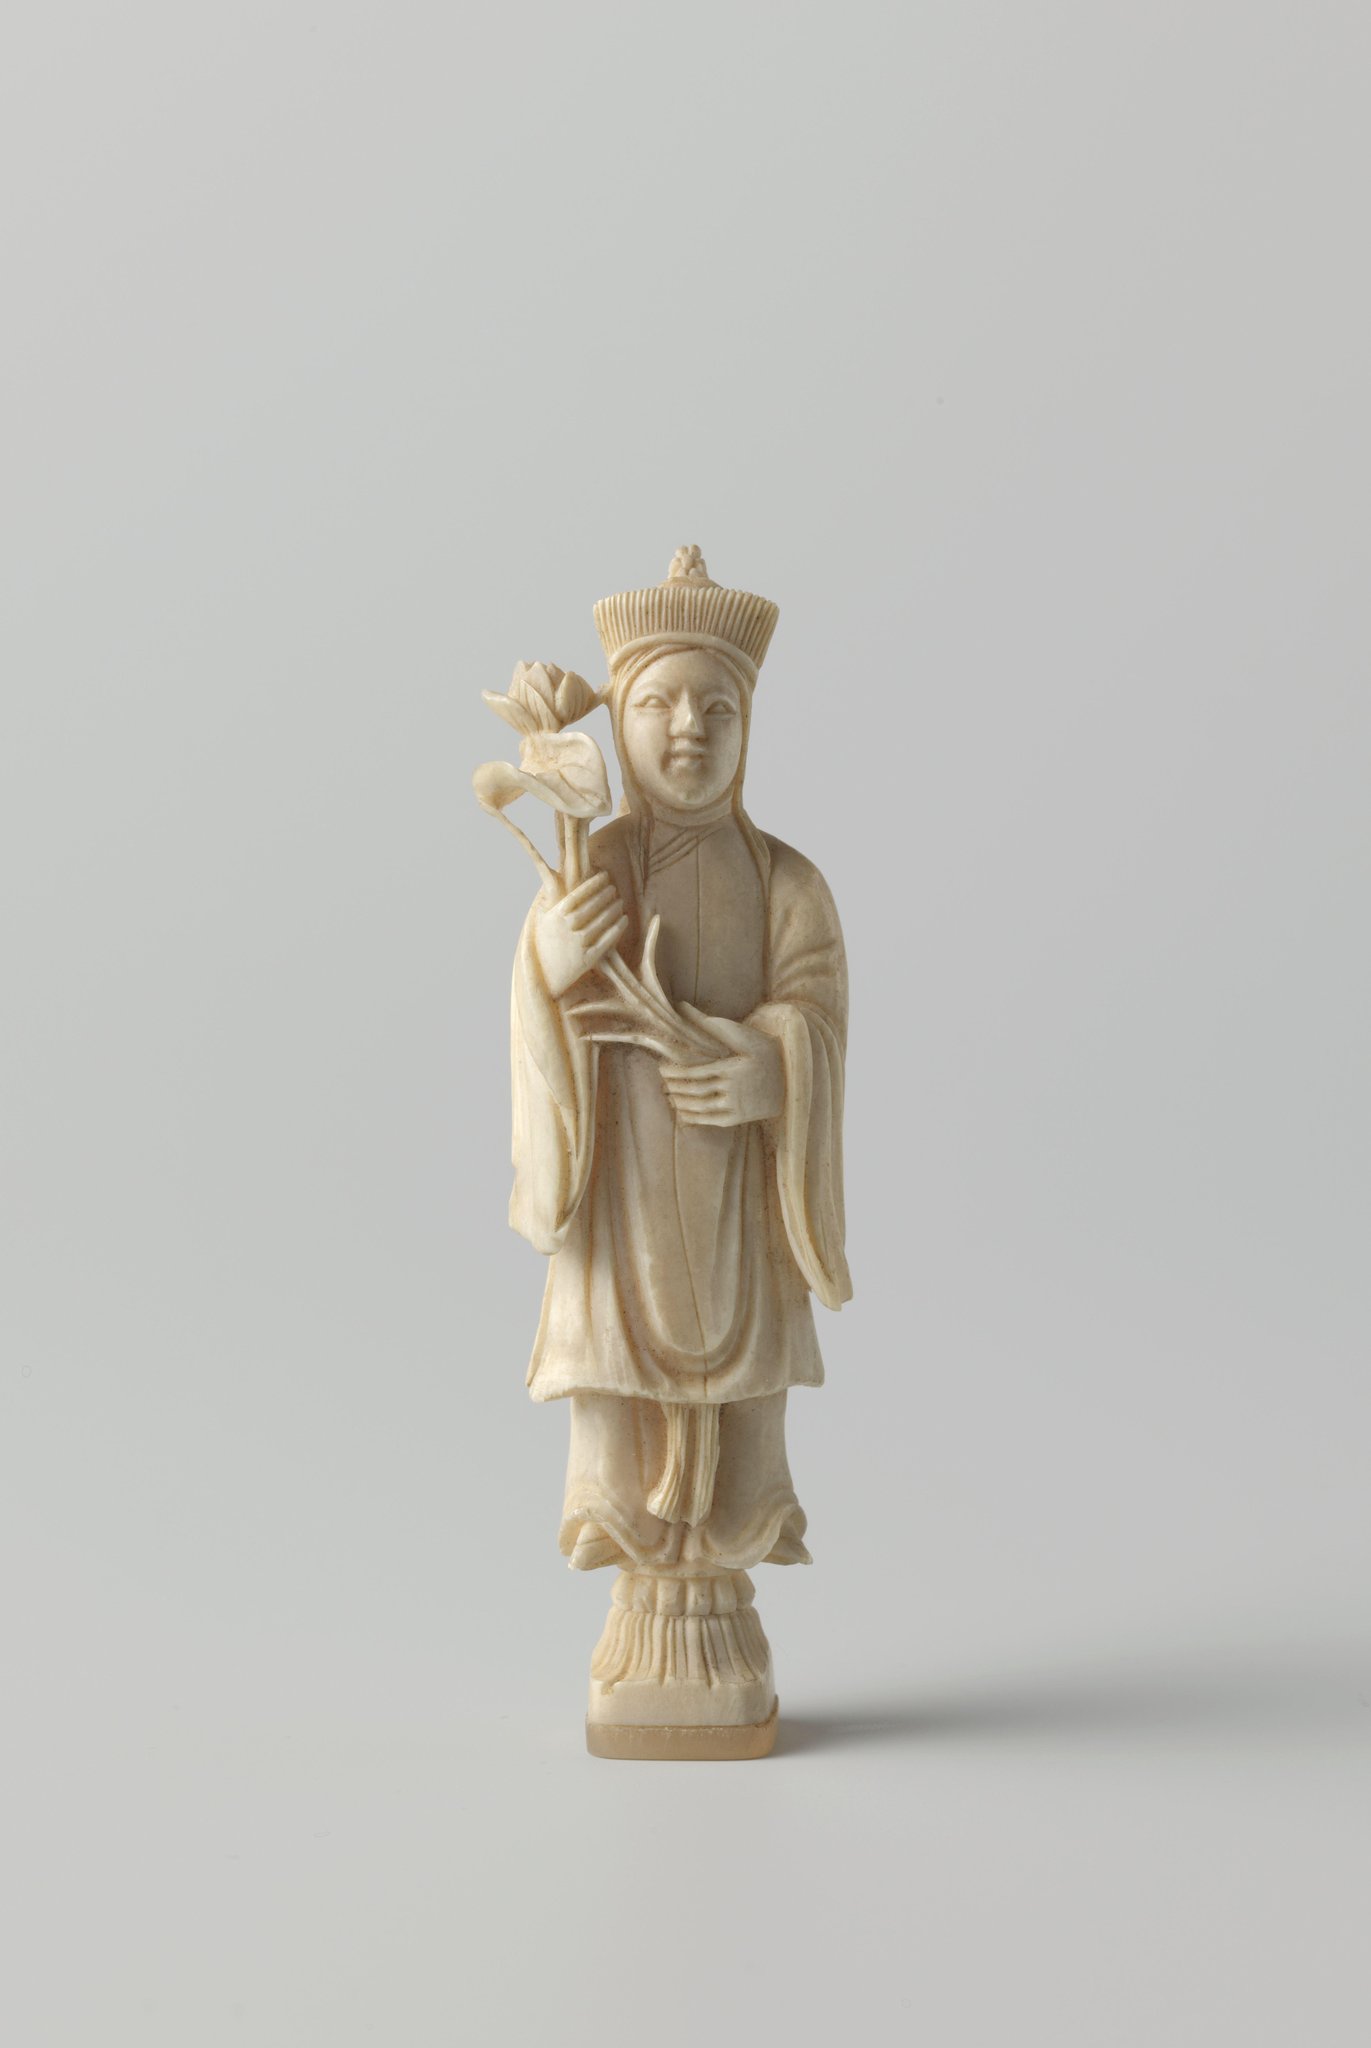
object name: cachet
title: Cachet met een ivoren handvat in de vorm van een Chinese vrouw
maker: Anonymous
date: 1800-1850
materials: ivory, mother of pearl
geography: china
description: Een cachet met een handvat in de vorm van een Chinese vrouw met een lotusbloem in de hand. Op het cachet zelf een staande leeuw.